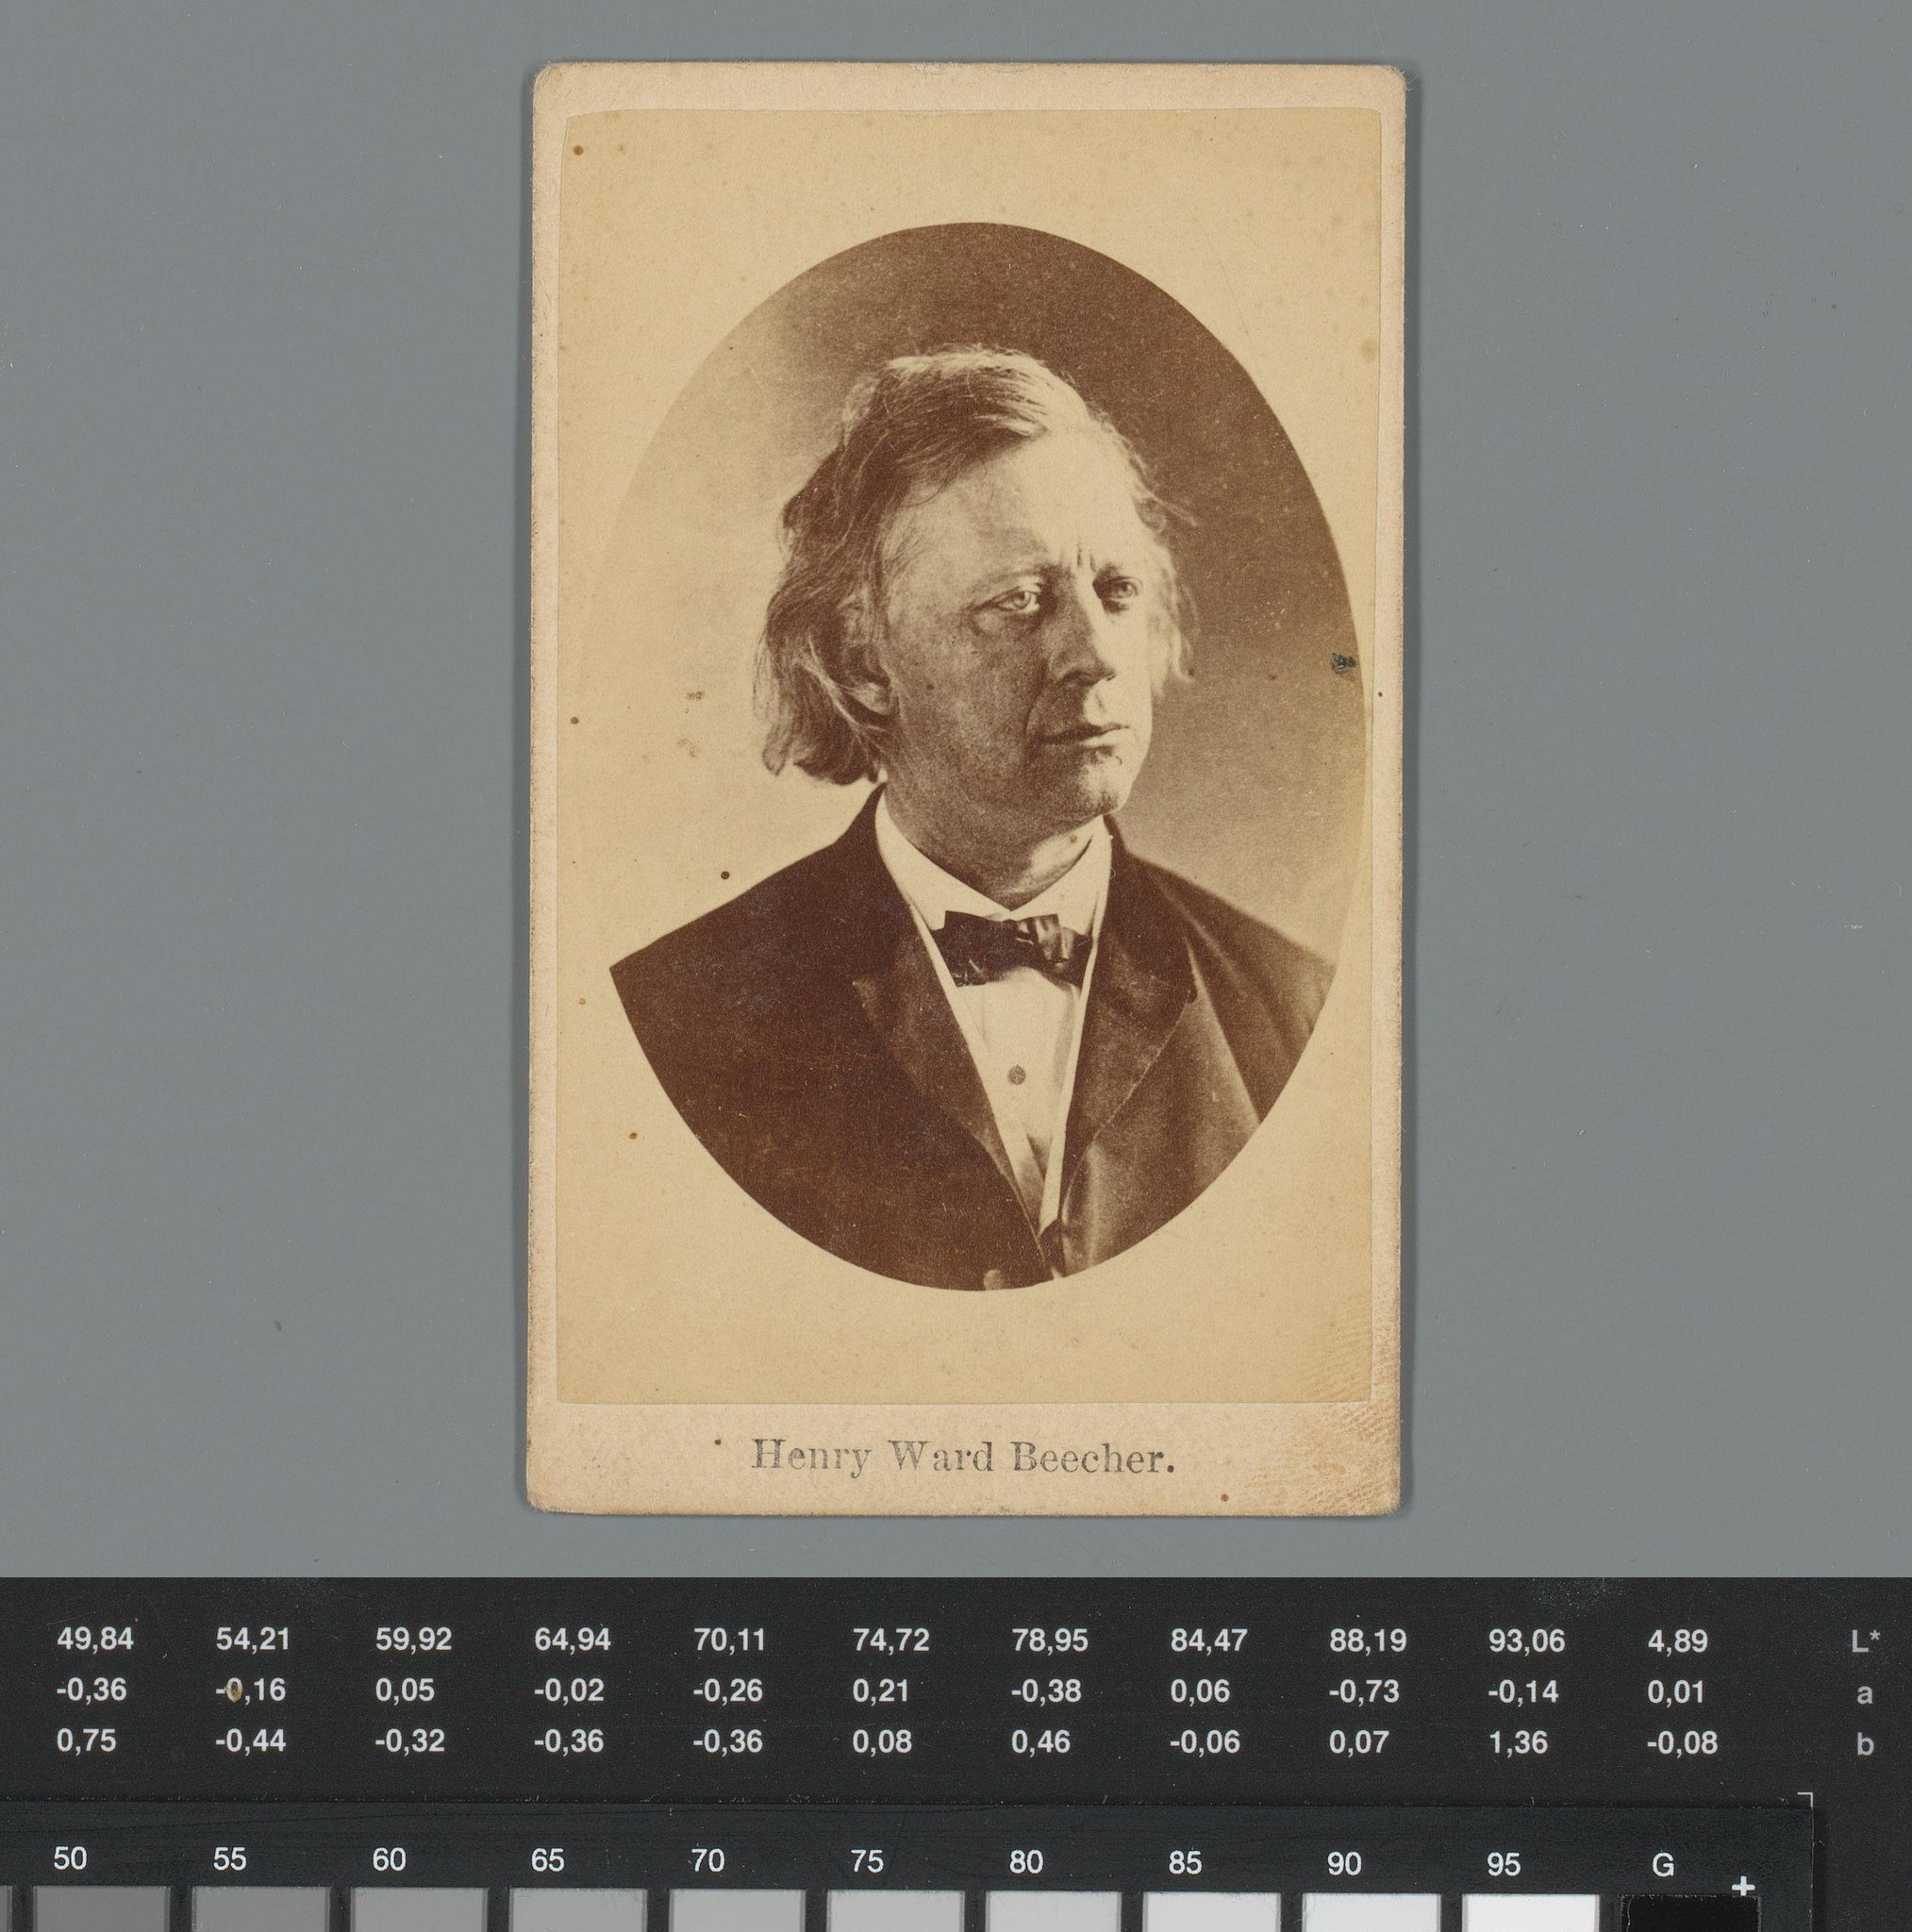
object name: photograph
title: Portret van Henry Ward Beecher met reclame voor juwelierszaak Goldsmith's Hall in Fergus, Ontario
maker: Anonymous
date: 1850-1887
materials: cardboard, photographic support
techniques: albumen print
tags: advertising, historical persons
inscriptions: inscription: ‘(...)’